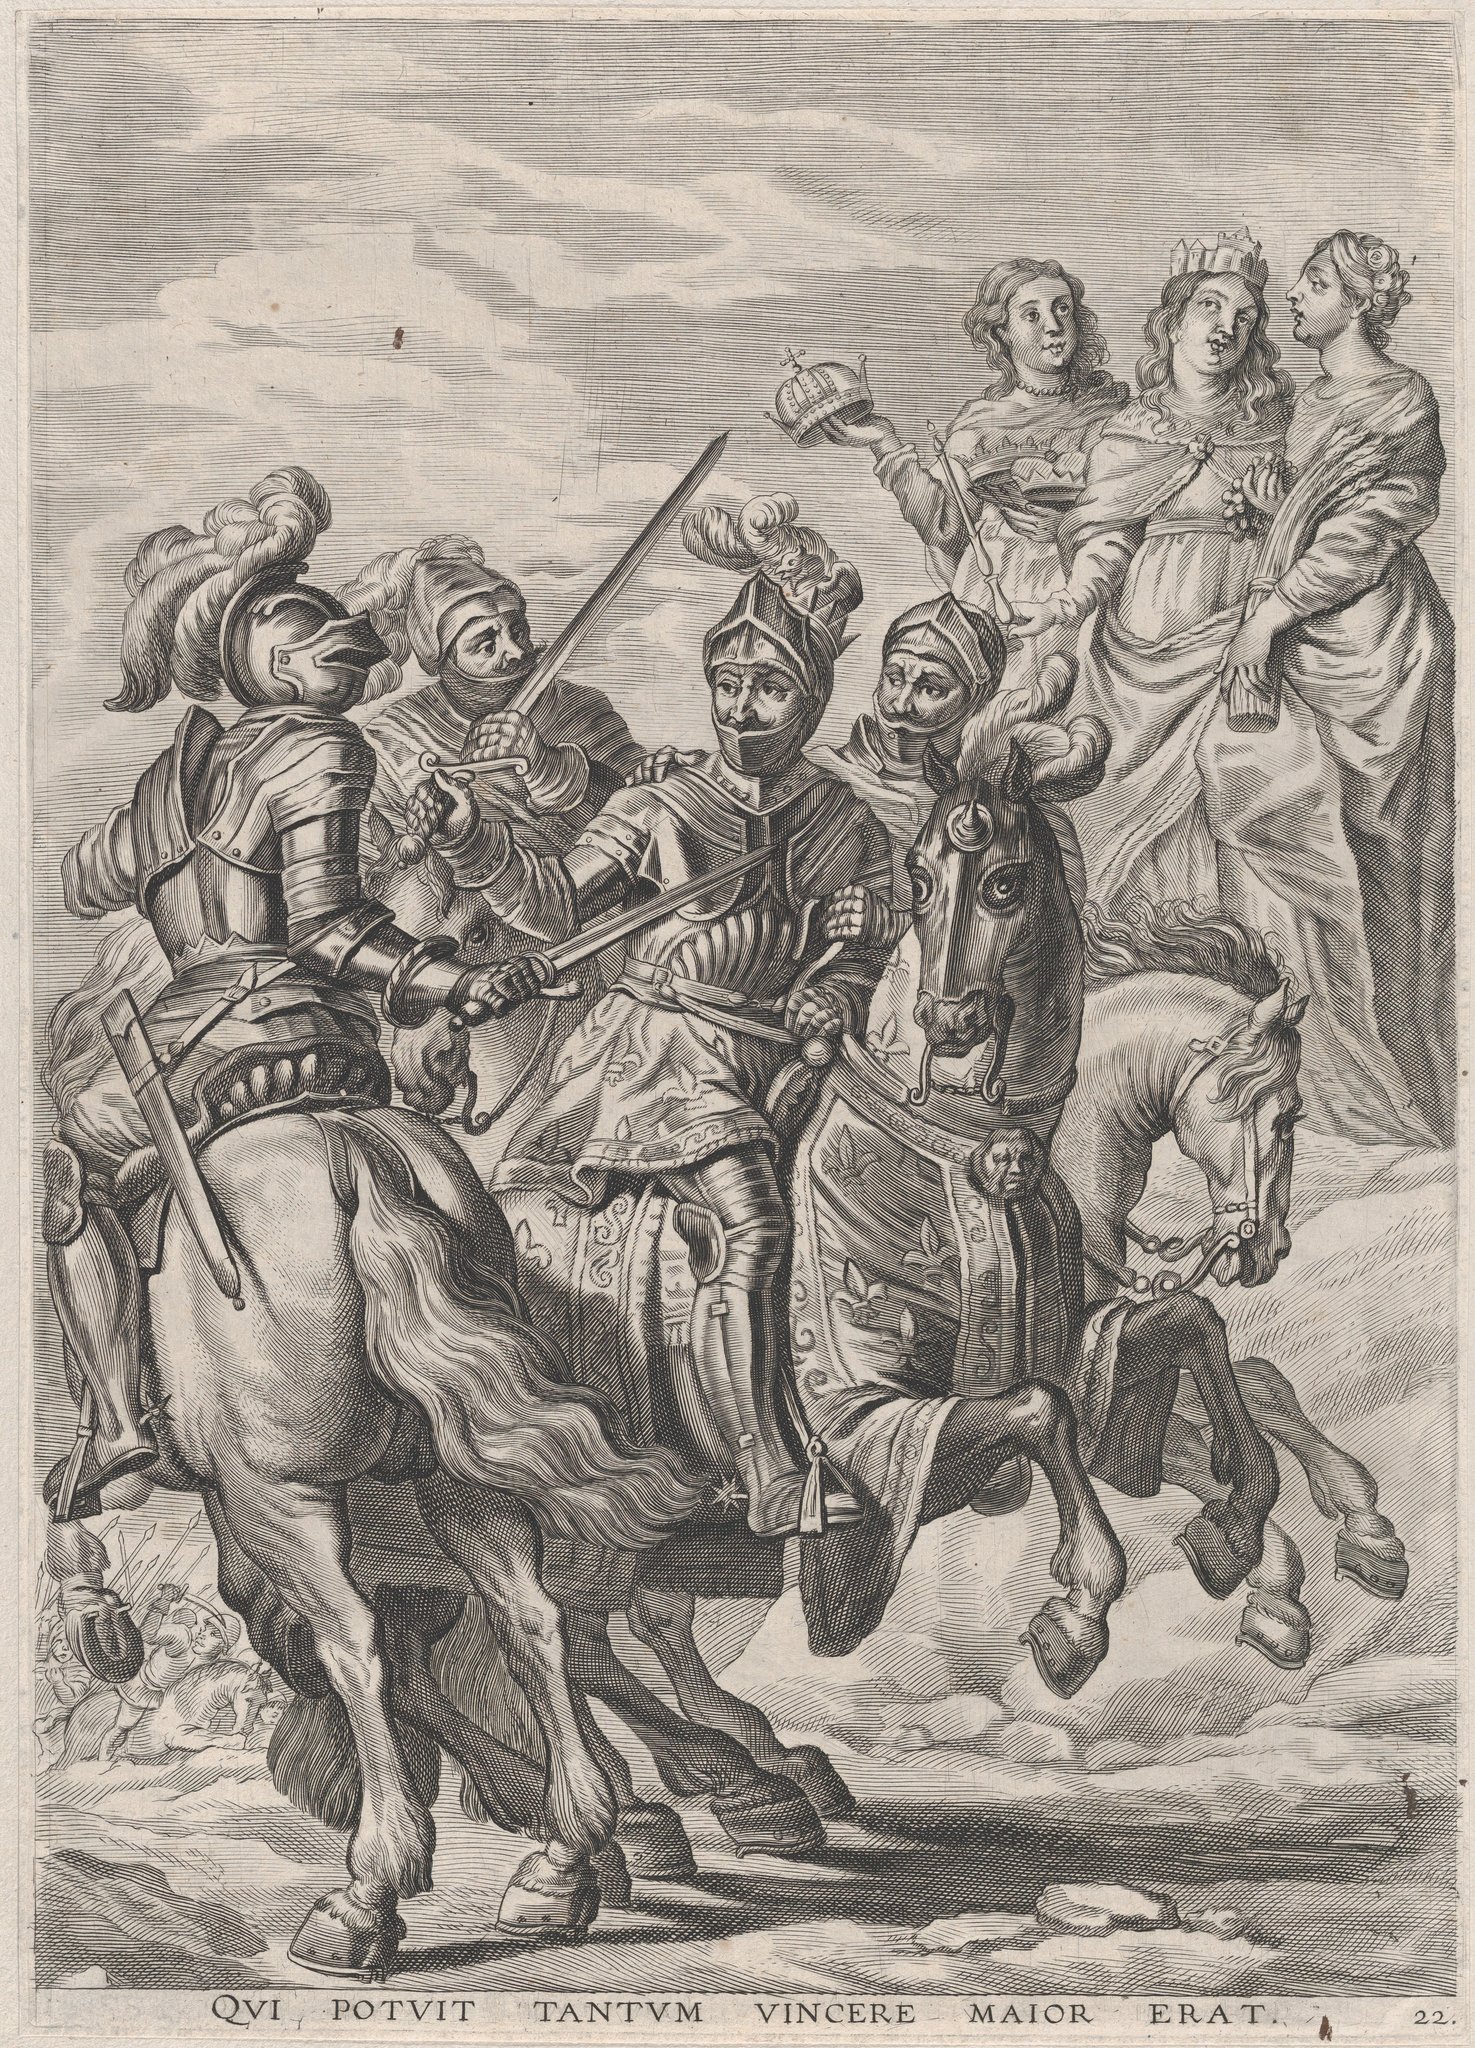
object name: print, fete, ornament architecture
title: Plate 22: Emperor Charles V, victory at Pavia; from Guillielmus Becanus's 'Serenissimi Principis Ferdinandi, Hispaniarum Infantis...'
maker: jacob neeffs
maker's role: artist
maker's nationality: flemish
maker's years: 1610-1670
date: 1636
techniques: engraving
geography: antwerp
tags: soldiers,swords,women,horses